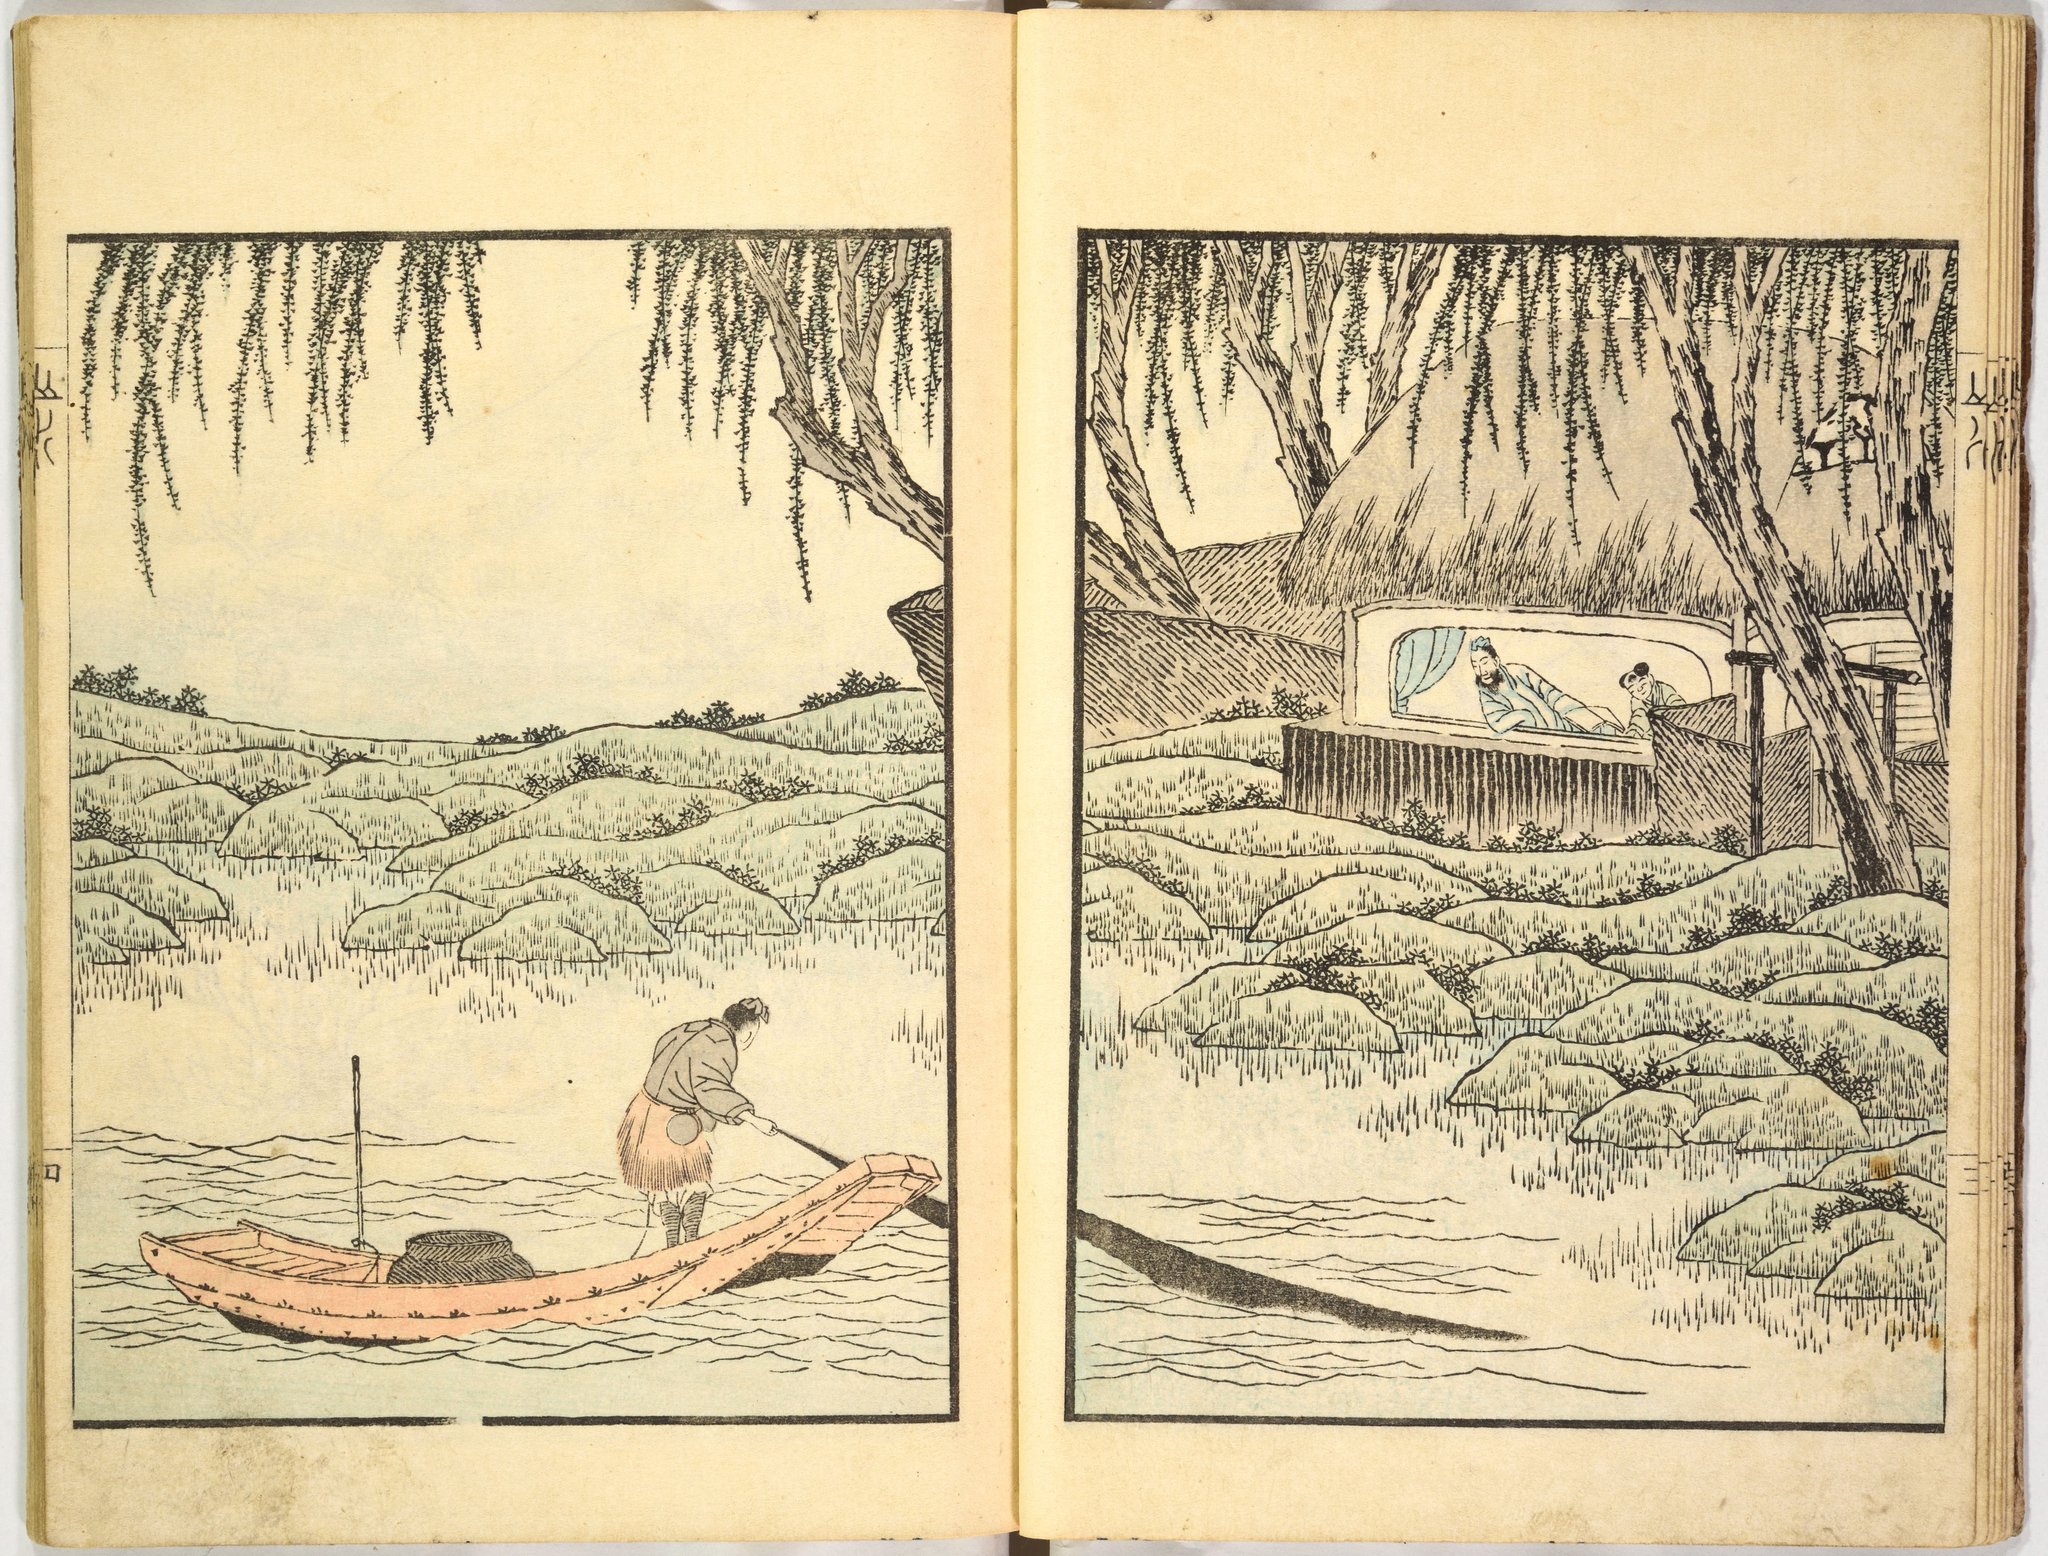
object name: illustrated book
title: Sketches by Ichirō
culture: japanese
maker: yajima ichiro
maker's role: artist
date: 1823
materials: ink, paper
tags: men,fishing,trees,boats